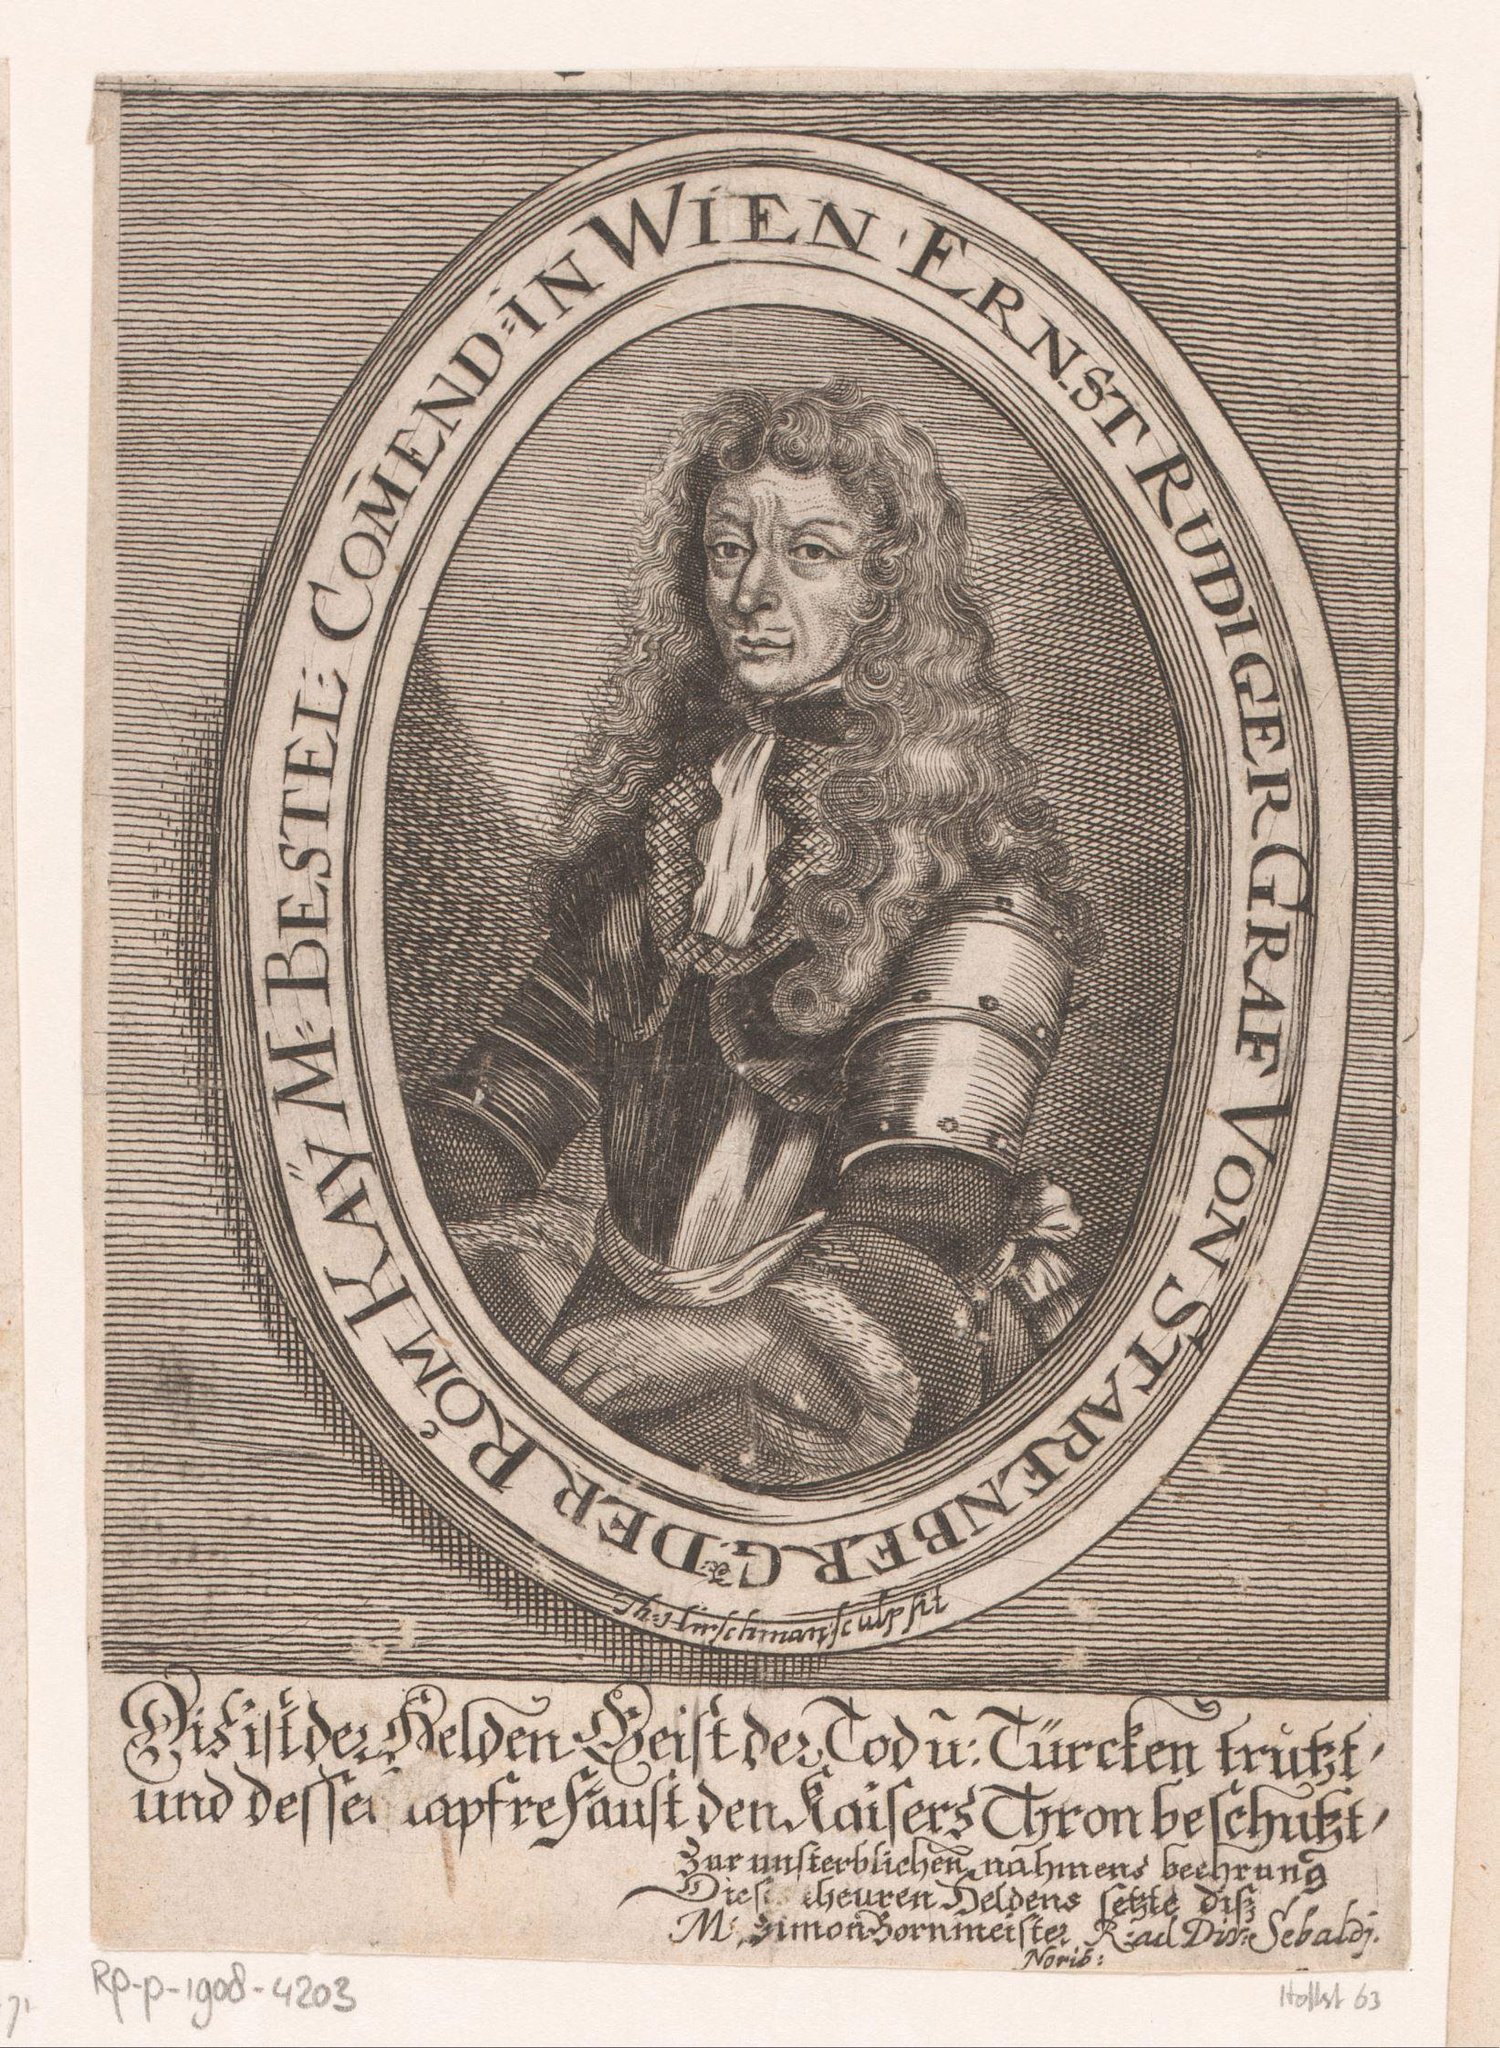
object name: print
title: Portret van Ernst Rüdiger van Starhemberg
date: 1670-1691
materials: paper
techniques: engraving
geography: nuremberg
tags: ernst rüdiger van starhemberg, armour, historical persons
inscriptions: collector's mark: Lugt 2228